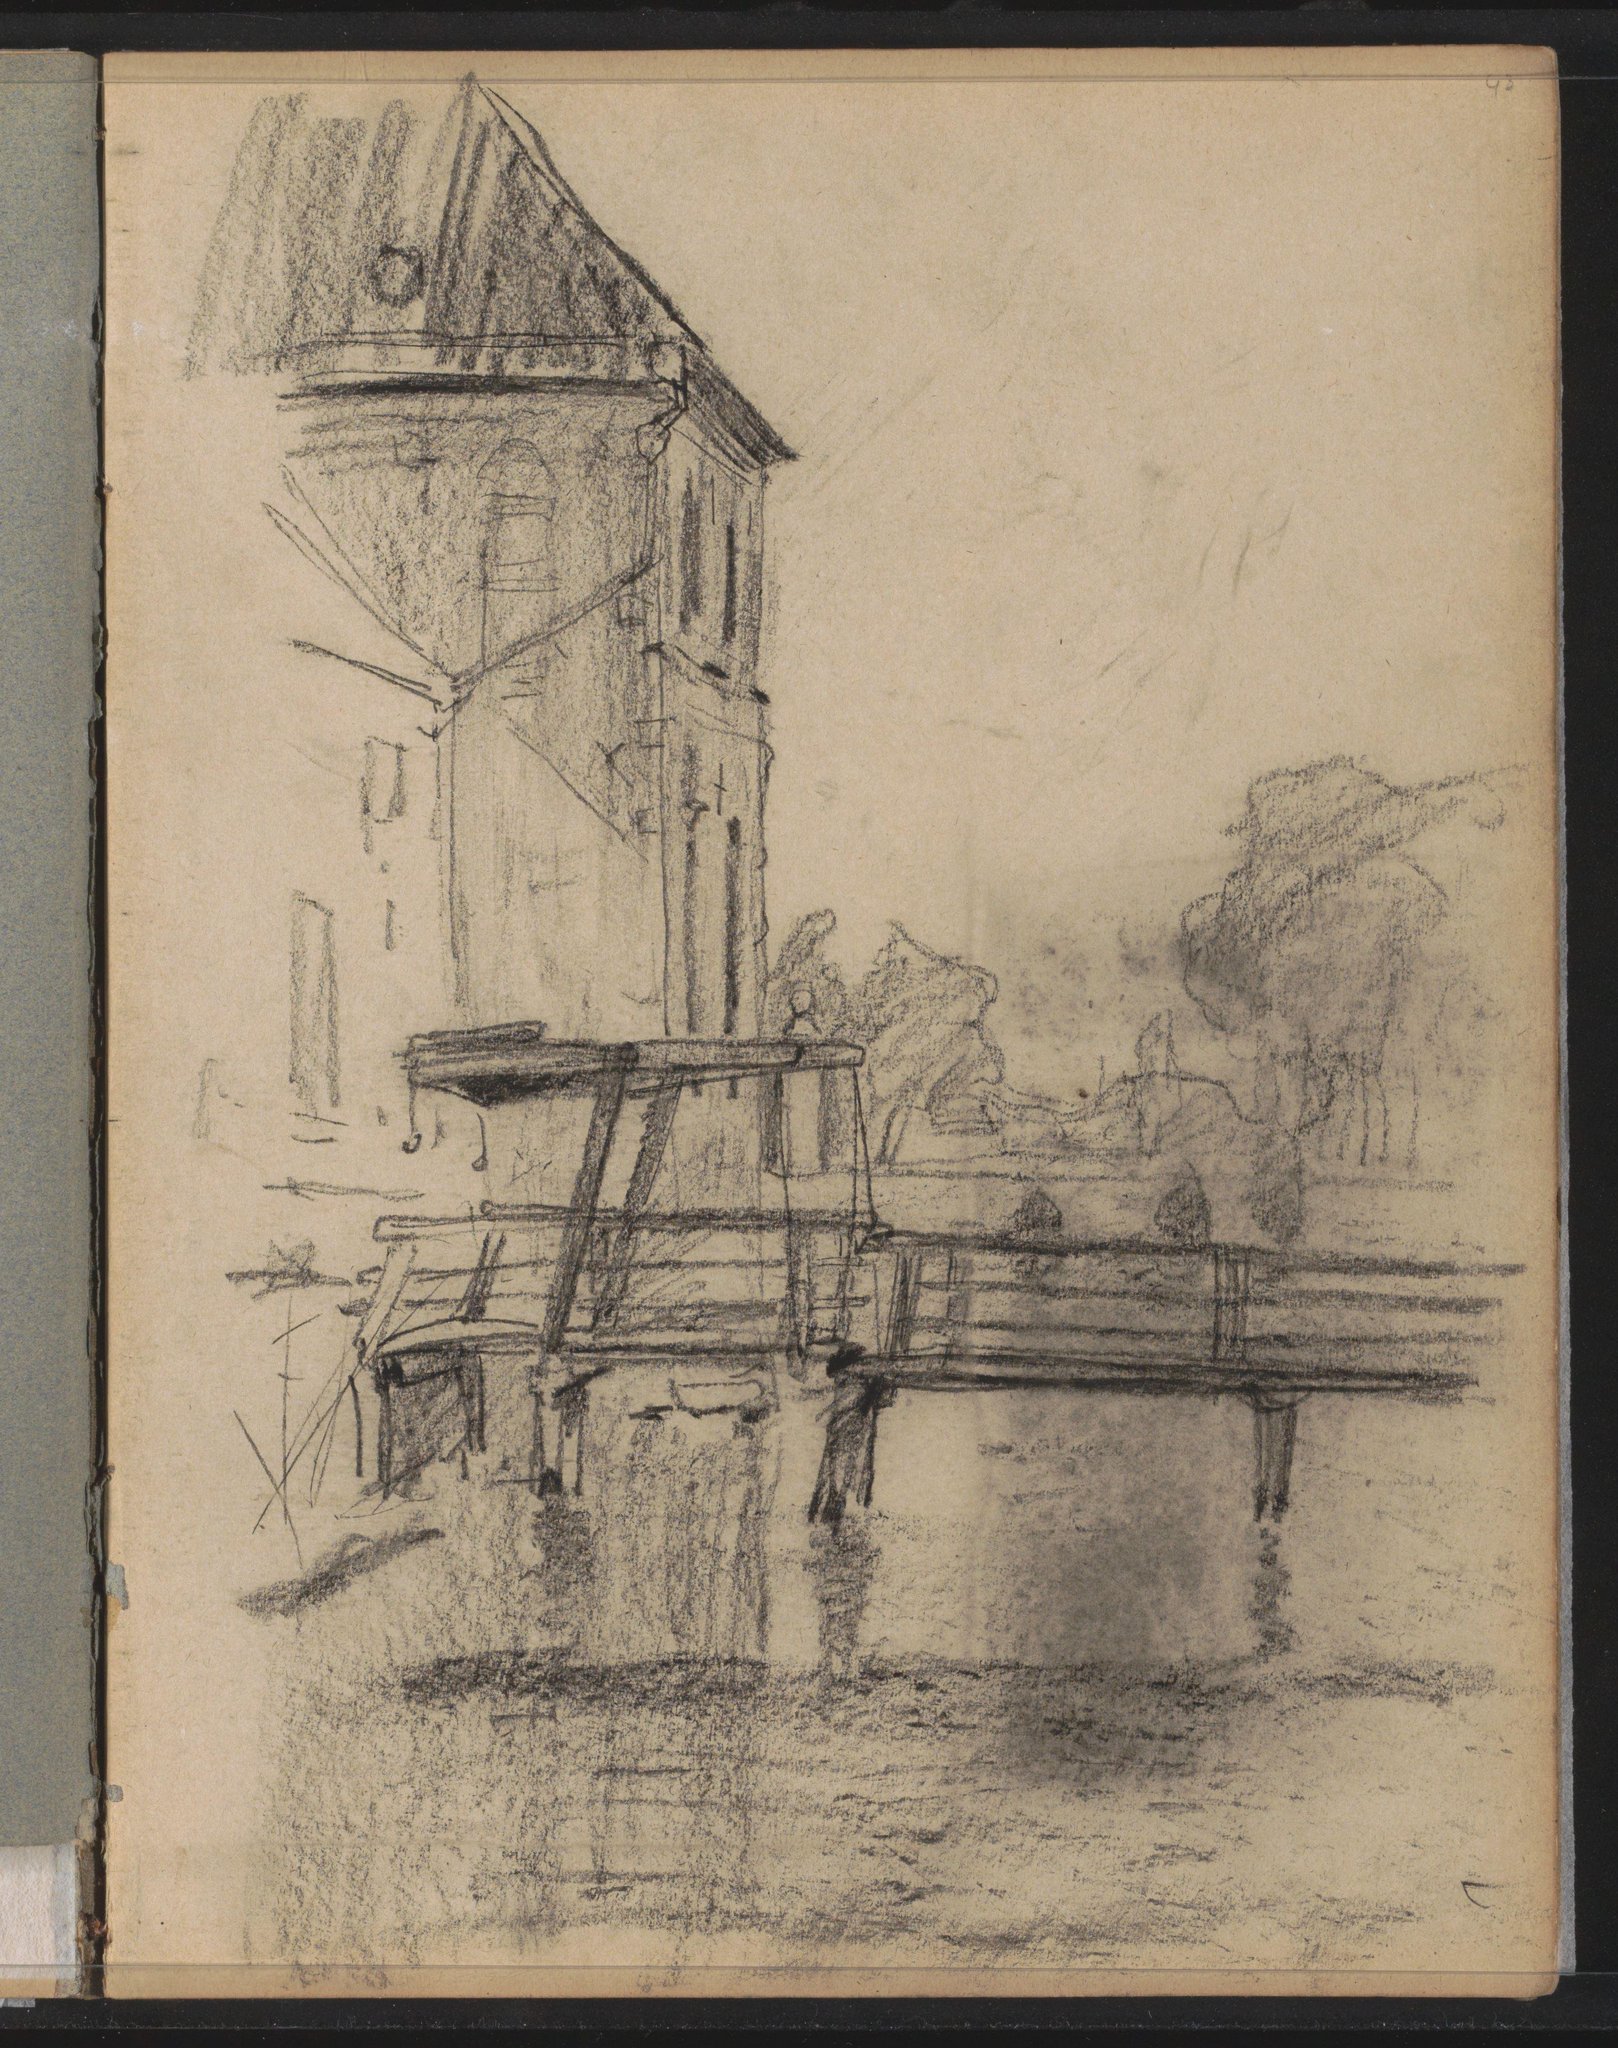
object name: sketchbook leaf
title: Ophaalbrug over een slotgracht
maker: willem witsen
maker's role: draughtsman, painter, print maker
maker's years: 1860-1923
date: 1887-1888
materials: chalk, paper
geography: diepenheim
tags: drawbridge ~ fortified city, moat ~ fortified city, rural housing, e.g. country-house, villa, cottage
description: Pagina 43 uit een schetsboek met 43 bladen.